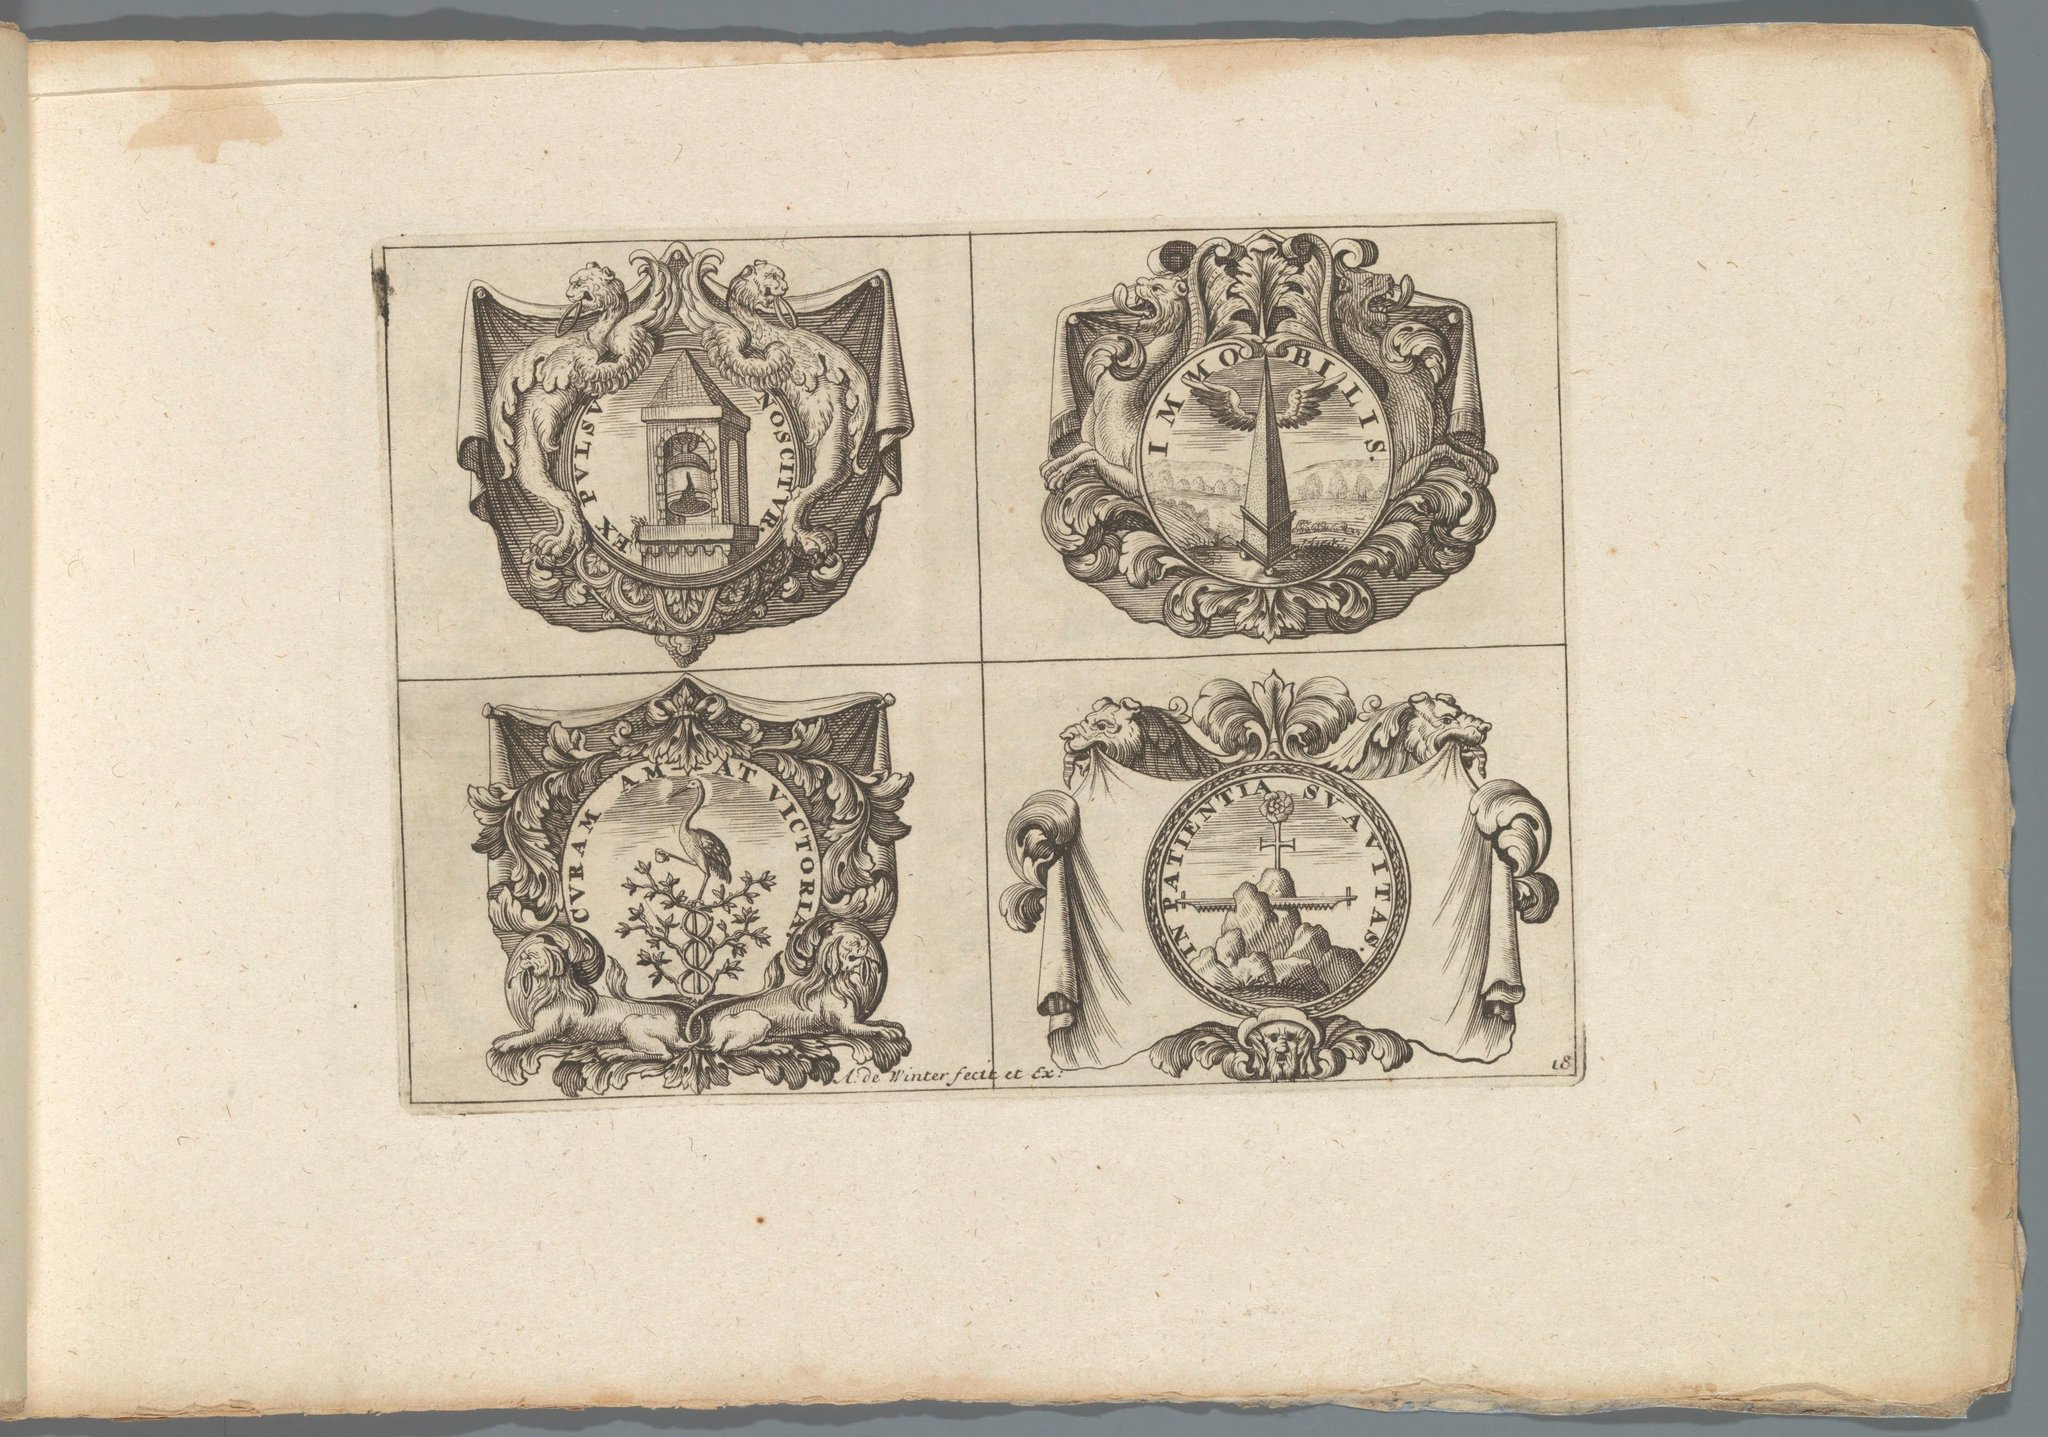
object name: print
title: Prent 18 uit serie "Livre des plus belles devises..."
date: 1697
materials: paper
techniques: etching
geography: amsterdam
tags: ornaments ~ art, symbolic representations, allegories and emblems ~mind, spirit, symbols of human life, love: 'frau minne' and other allegories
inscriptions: date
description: Prent nr. 18 van een serie van twaalf genummerde prenten (inclusief titelblad) met deviezen betreffende de liefde en andere levenszaken. De deviezen bestaan uit een pictura en een motto in het Latijn. Deel twee van twee genummerde reeksen. Het is de eerste uitgave (en eerste staat) van de uitgave, voor het adres van Cornelis Danckerts II en de toevoeging van Nederlandse teksten.